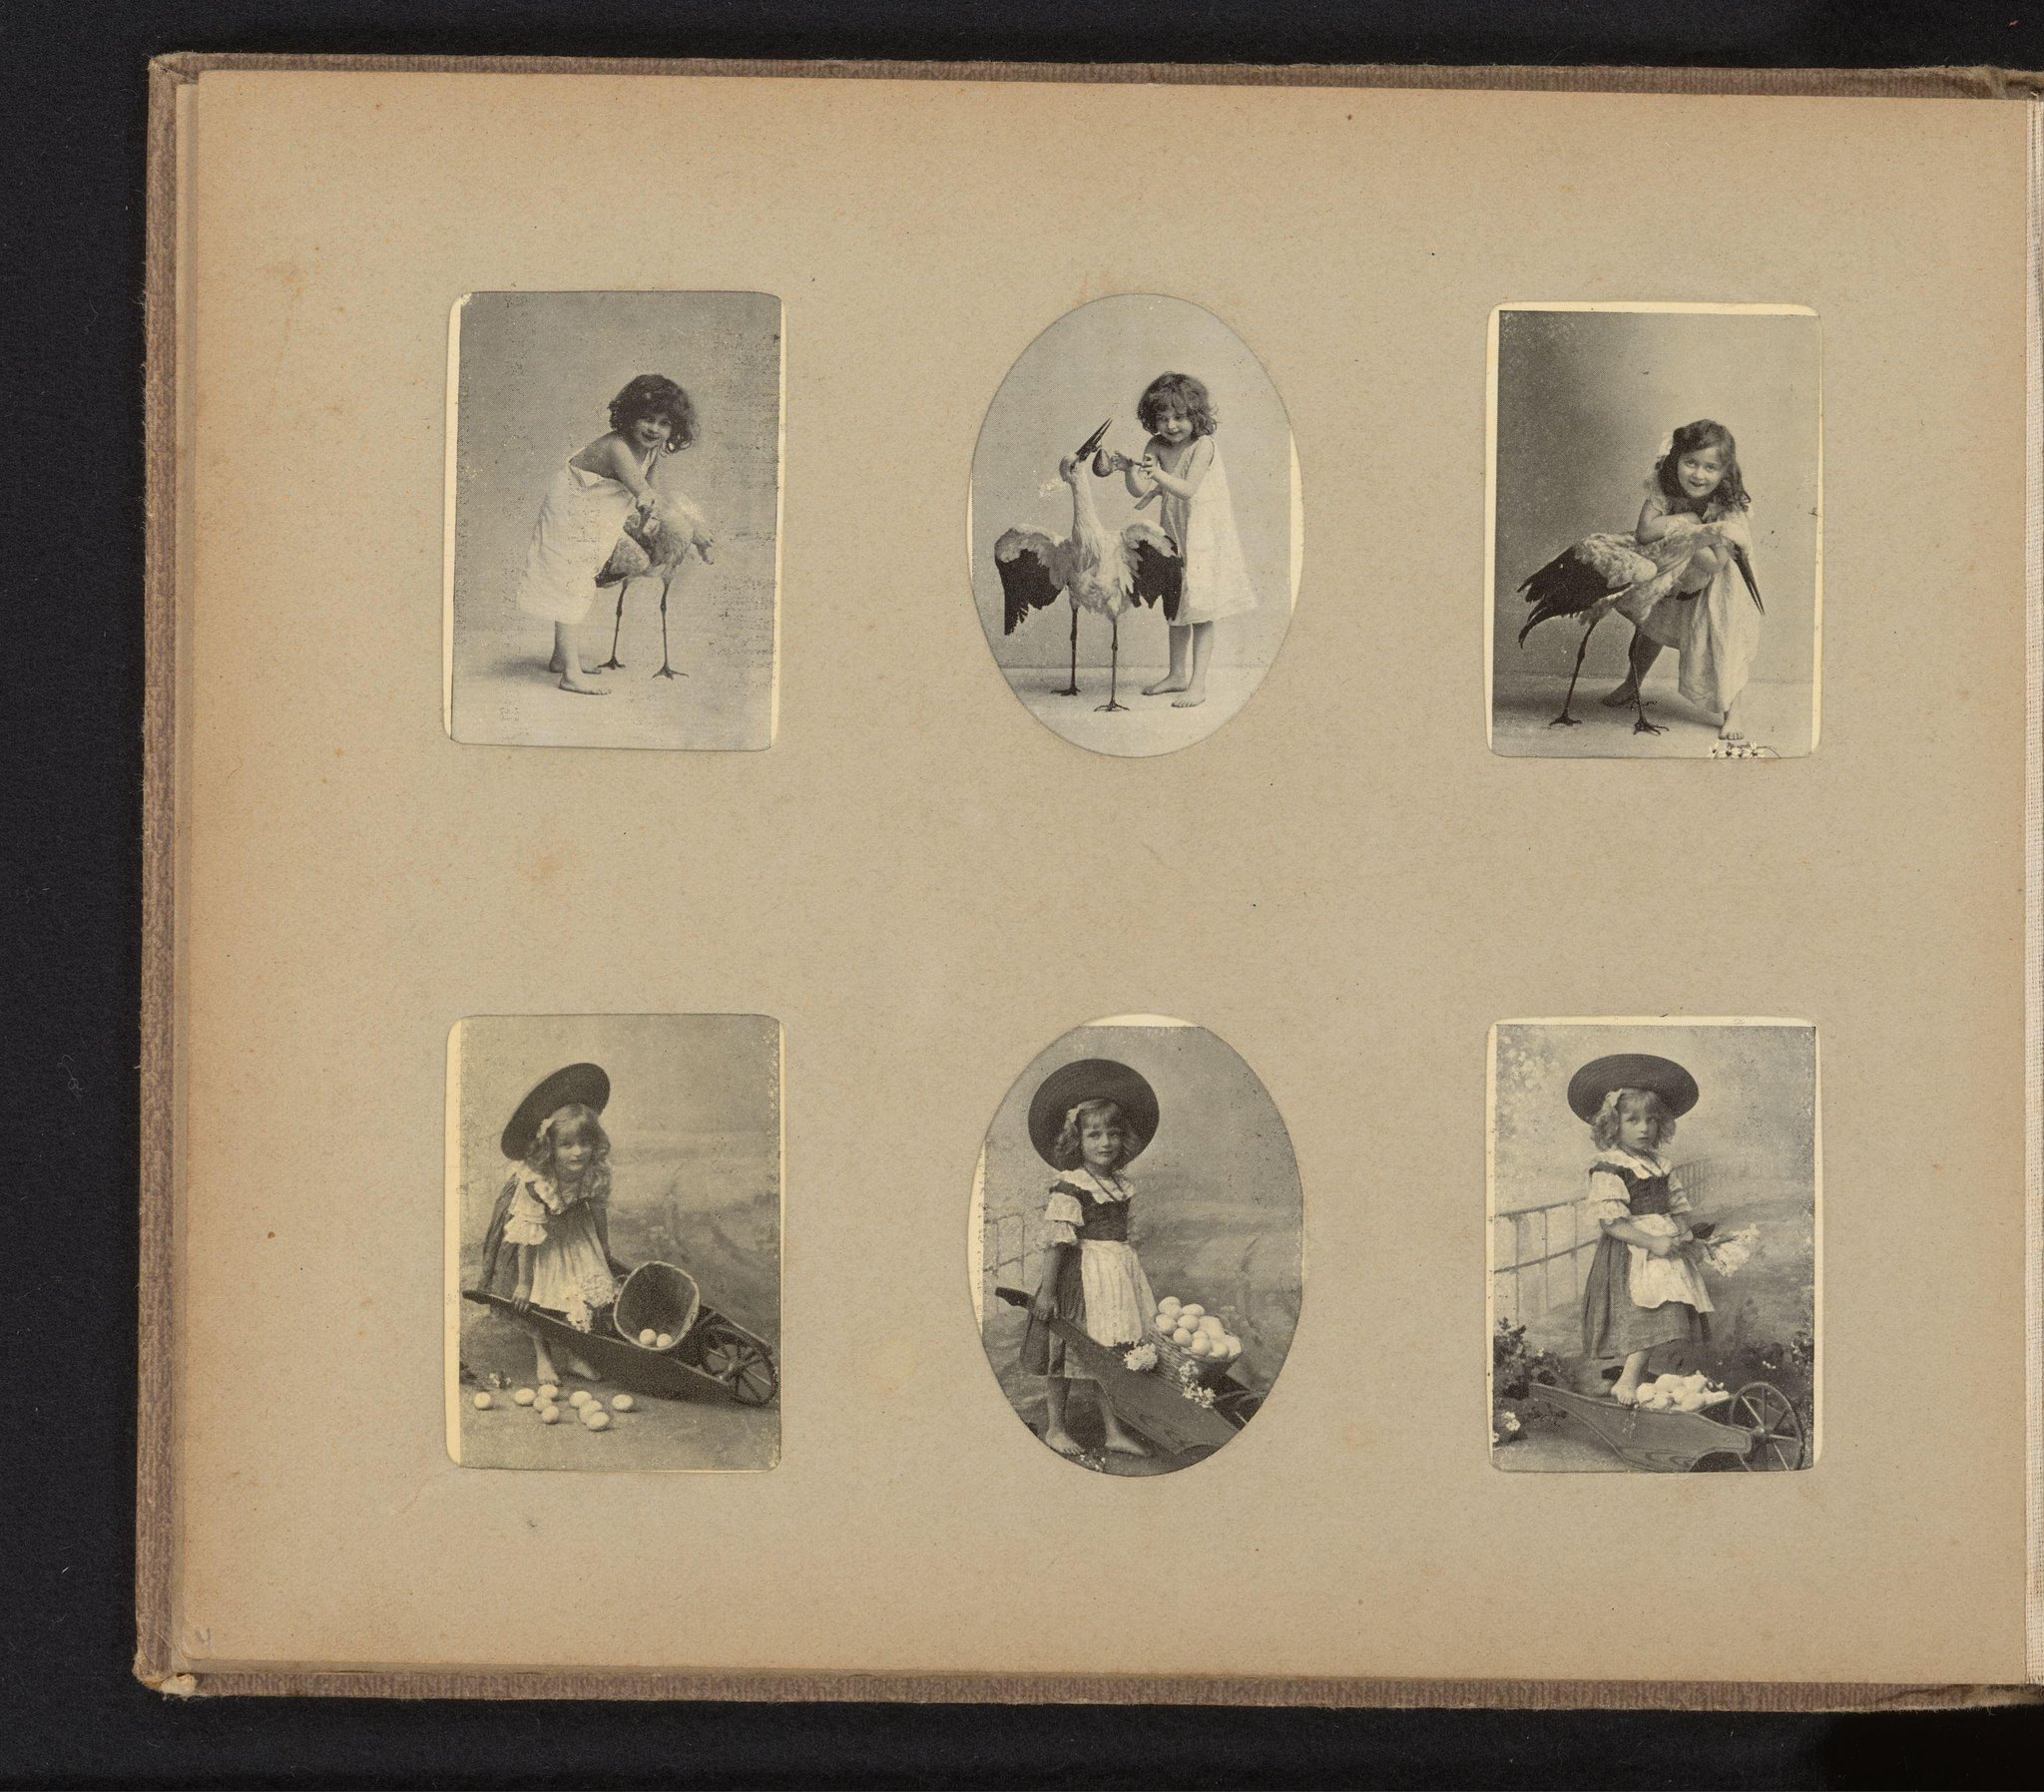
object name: photomechanical print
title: Kinderportretten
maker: Anonymous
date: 1890-1900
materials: cardboard, paper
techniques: autotype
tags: shore-birds and wading-birds: stork, wheelbarrow, child (at home)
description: Zes portretten van kinderen, waaronder drie van een meisje met een ooievaar en drie van een meisje met een kruiwagen. Deze pagina is deel van een album.